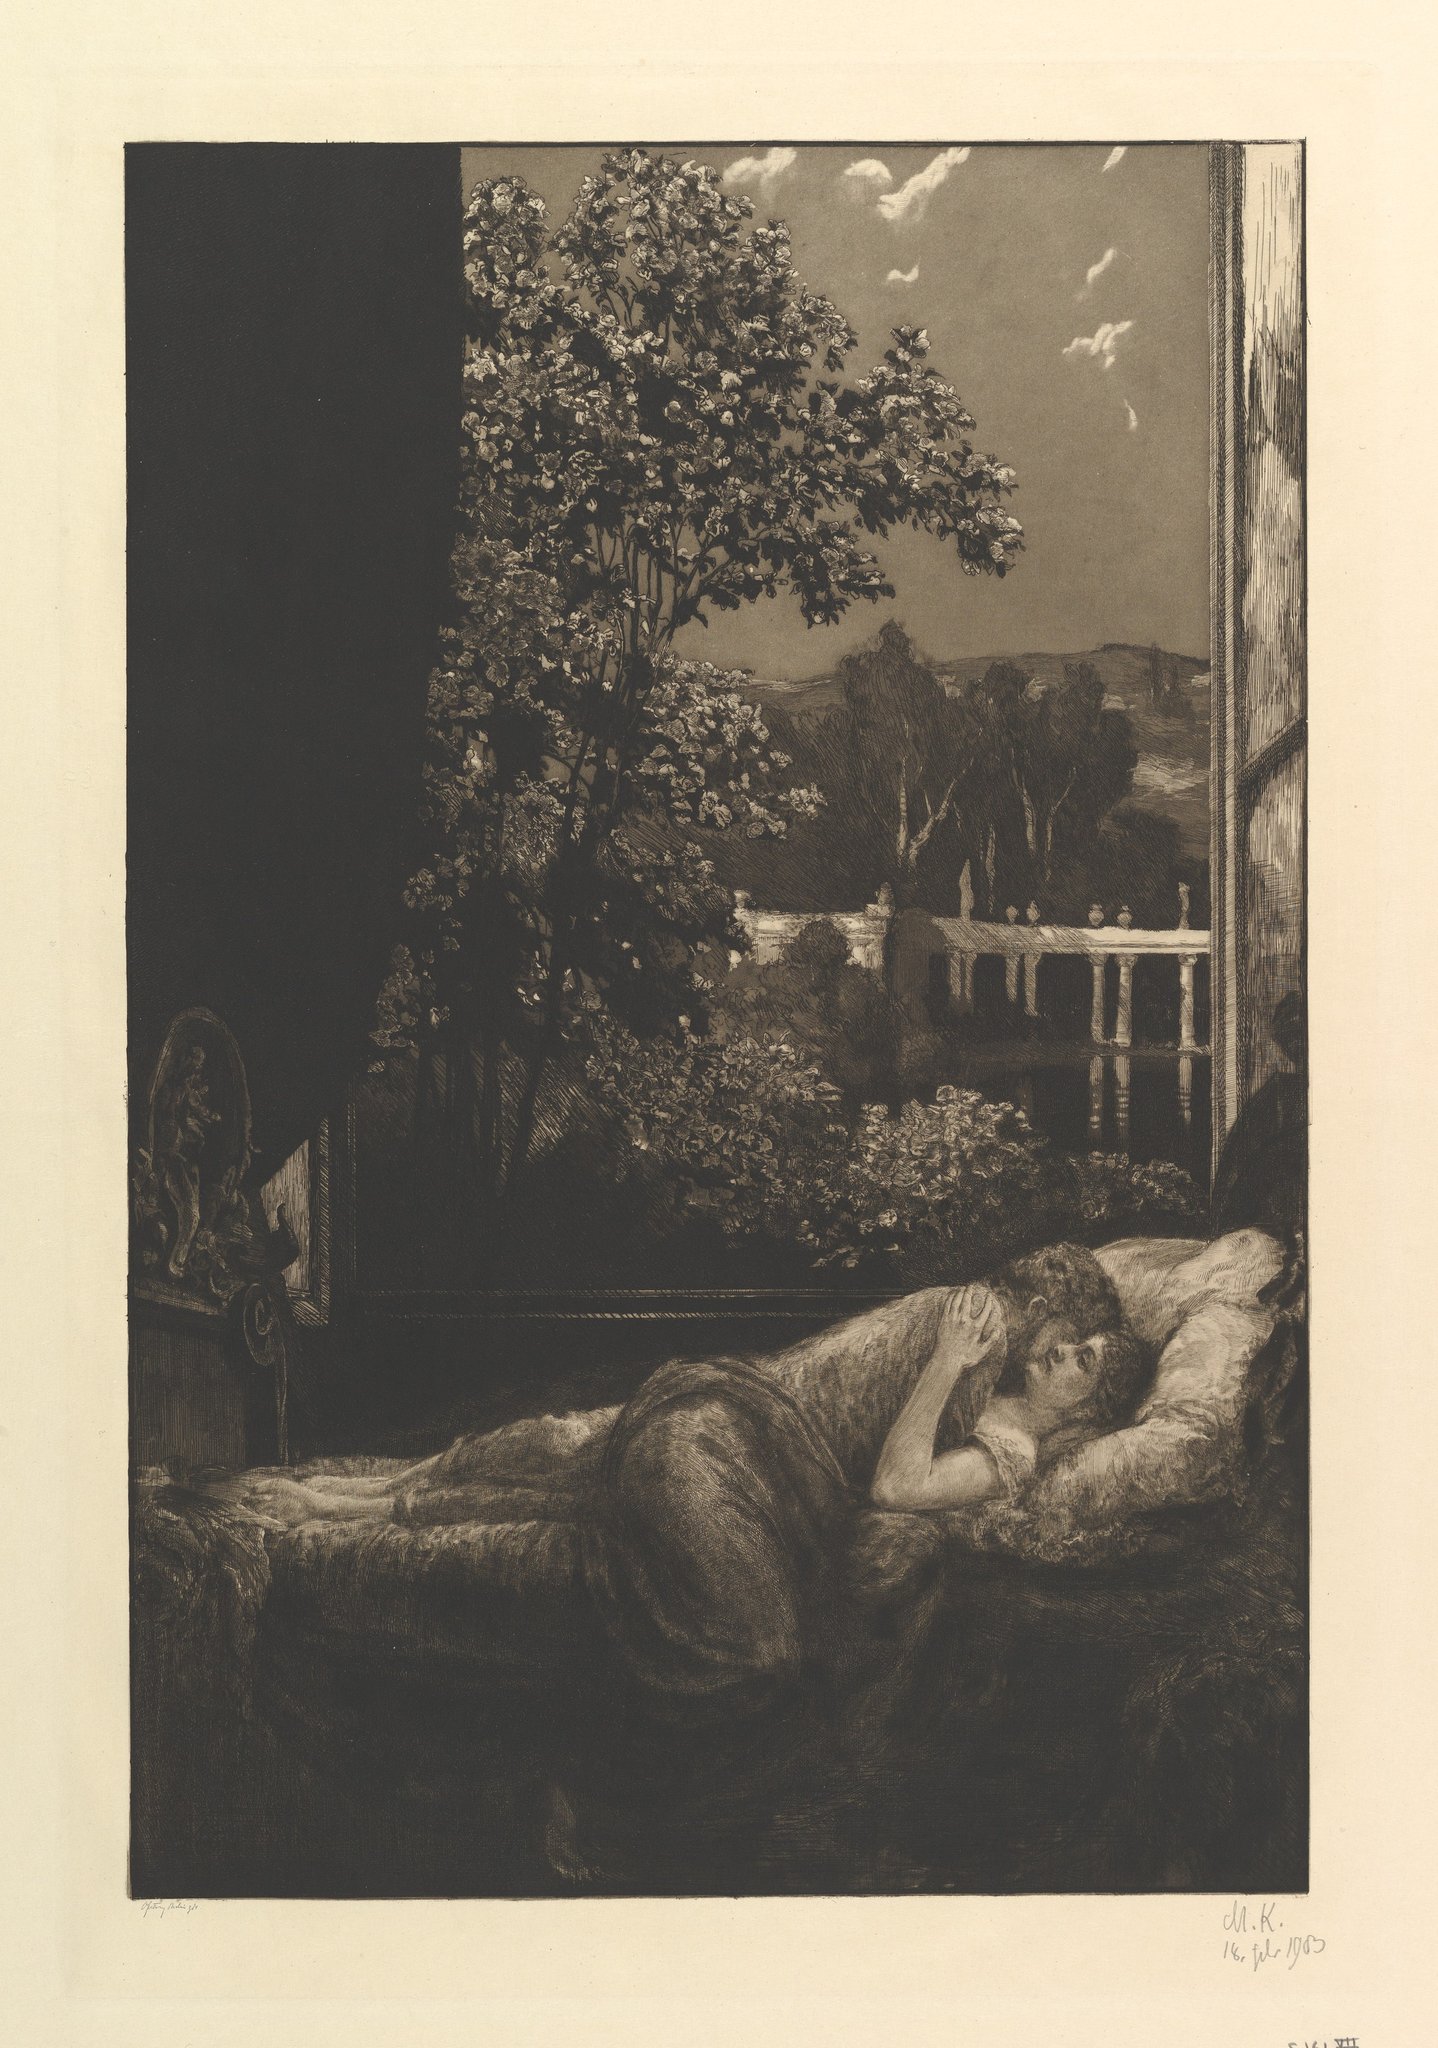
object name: print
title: Happiness (from the series A Love)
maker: max klinger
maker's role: artist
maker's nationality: german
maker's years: 1857-1920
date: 1887-1903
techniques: aquatint, engraving, etching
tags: couples,men,women